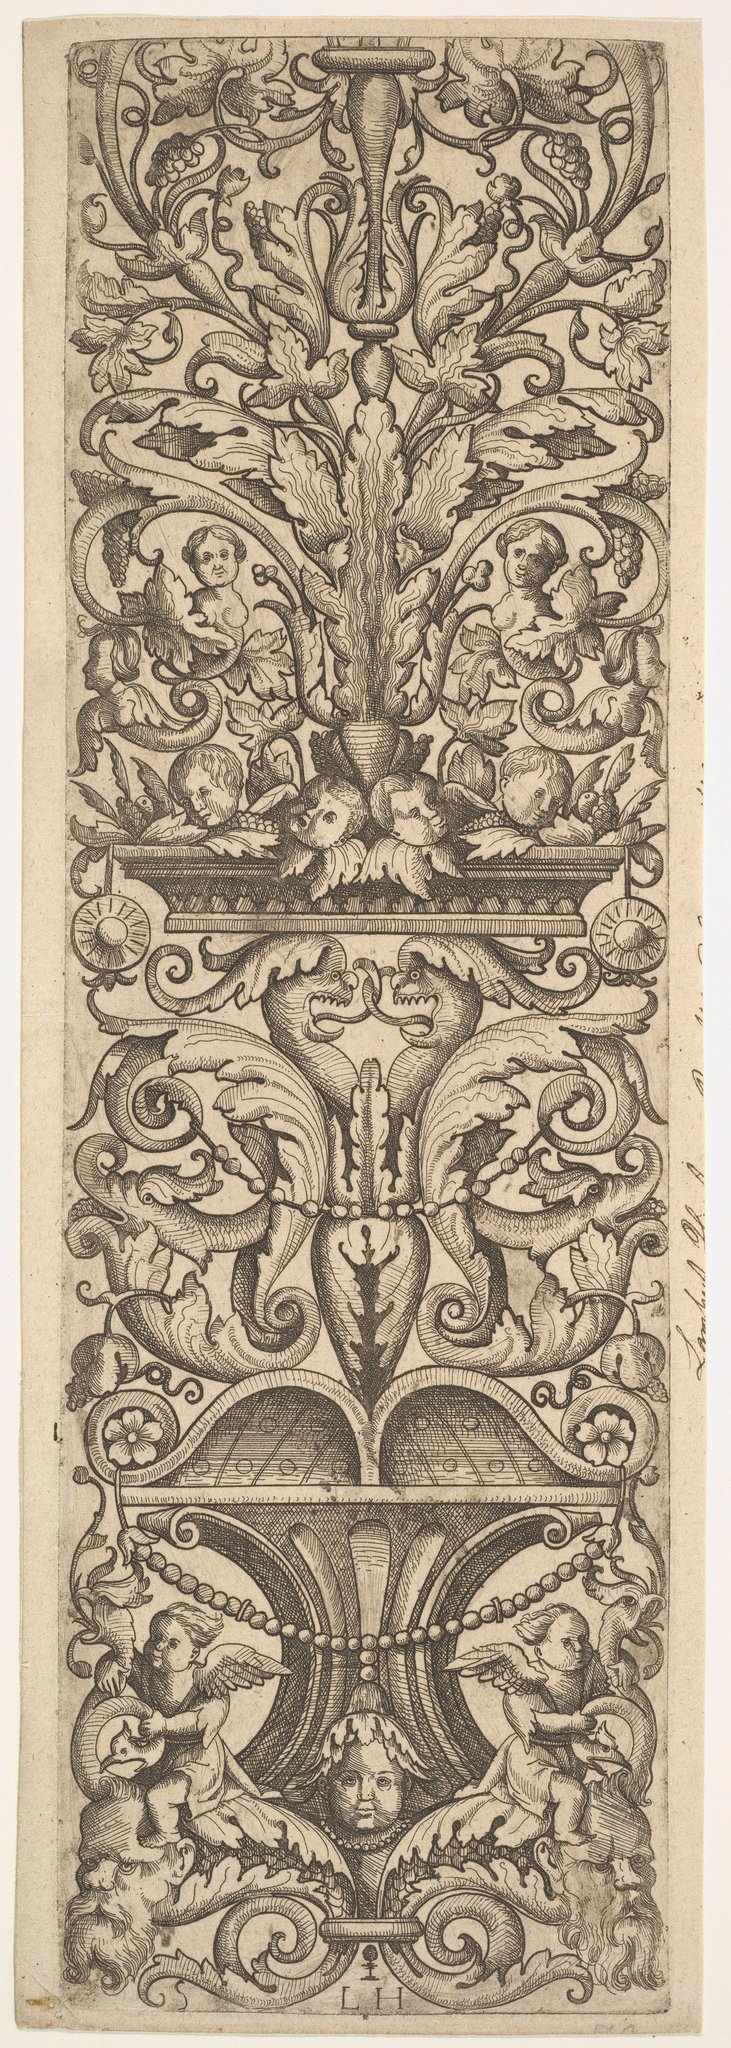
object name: print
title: Candelabra Grotesque with Heads of Dolphins and Dragons in the Center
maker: lambrecht hopfer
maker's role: artist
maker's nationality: german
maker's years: 1525-1550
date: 1525-1550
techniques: etching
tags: ornament,faces,female nudes,dragons